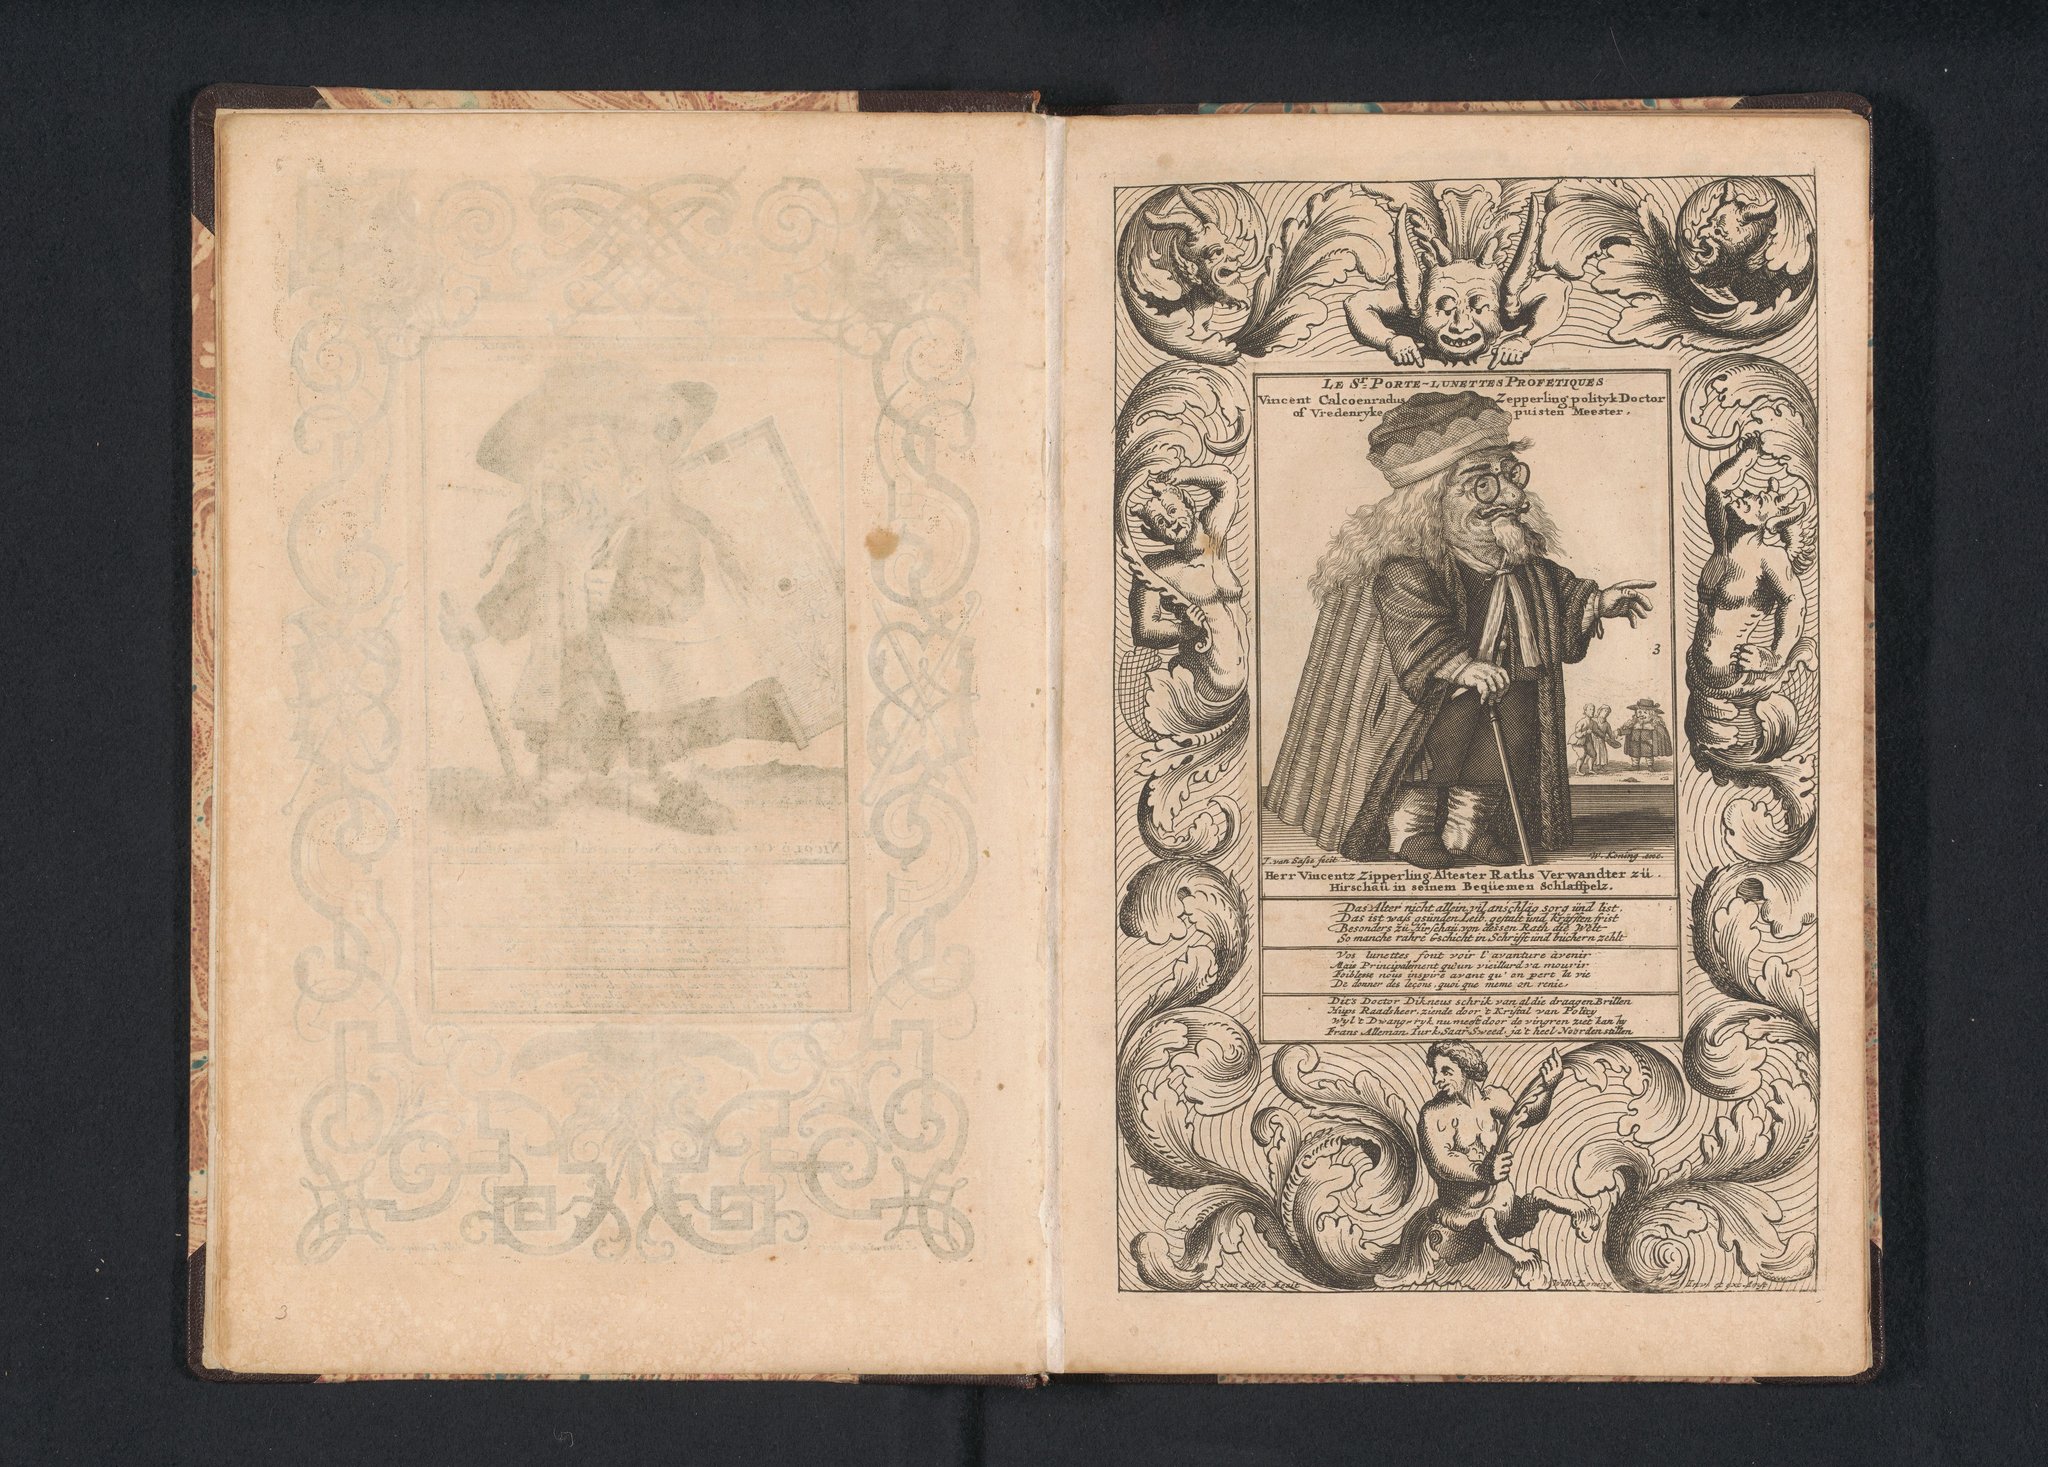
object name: print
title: Il Callotto resuscitato oder Neü eingerichtes Zwerchen Cabinet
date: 1716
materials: paper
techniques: etching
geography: amsterdam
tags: caricatures (human types), little people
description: De kleine mens Vincent Calcoenradus Zepperling in een bontjas. In het onderschrift verzen in het Duits, Frans en Nederlands. Afdruk binnen een decoratieve omlijsting gedrukt van een aparte plaat met bladwerk en duivels. Genummerd rechts midden: 3. Onderdeel van de Nederlandse gebonden uitgave uit 1716 van een serie karikaturen van kleine mensen, bekend als Het Dwergentooneel, gekopieerd naar een ouder Duits voorbeeld.